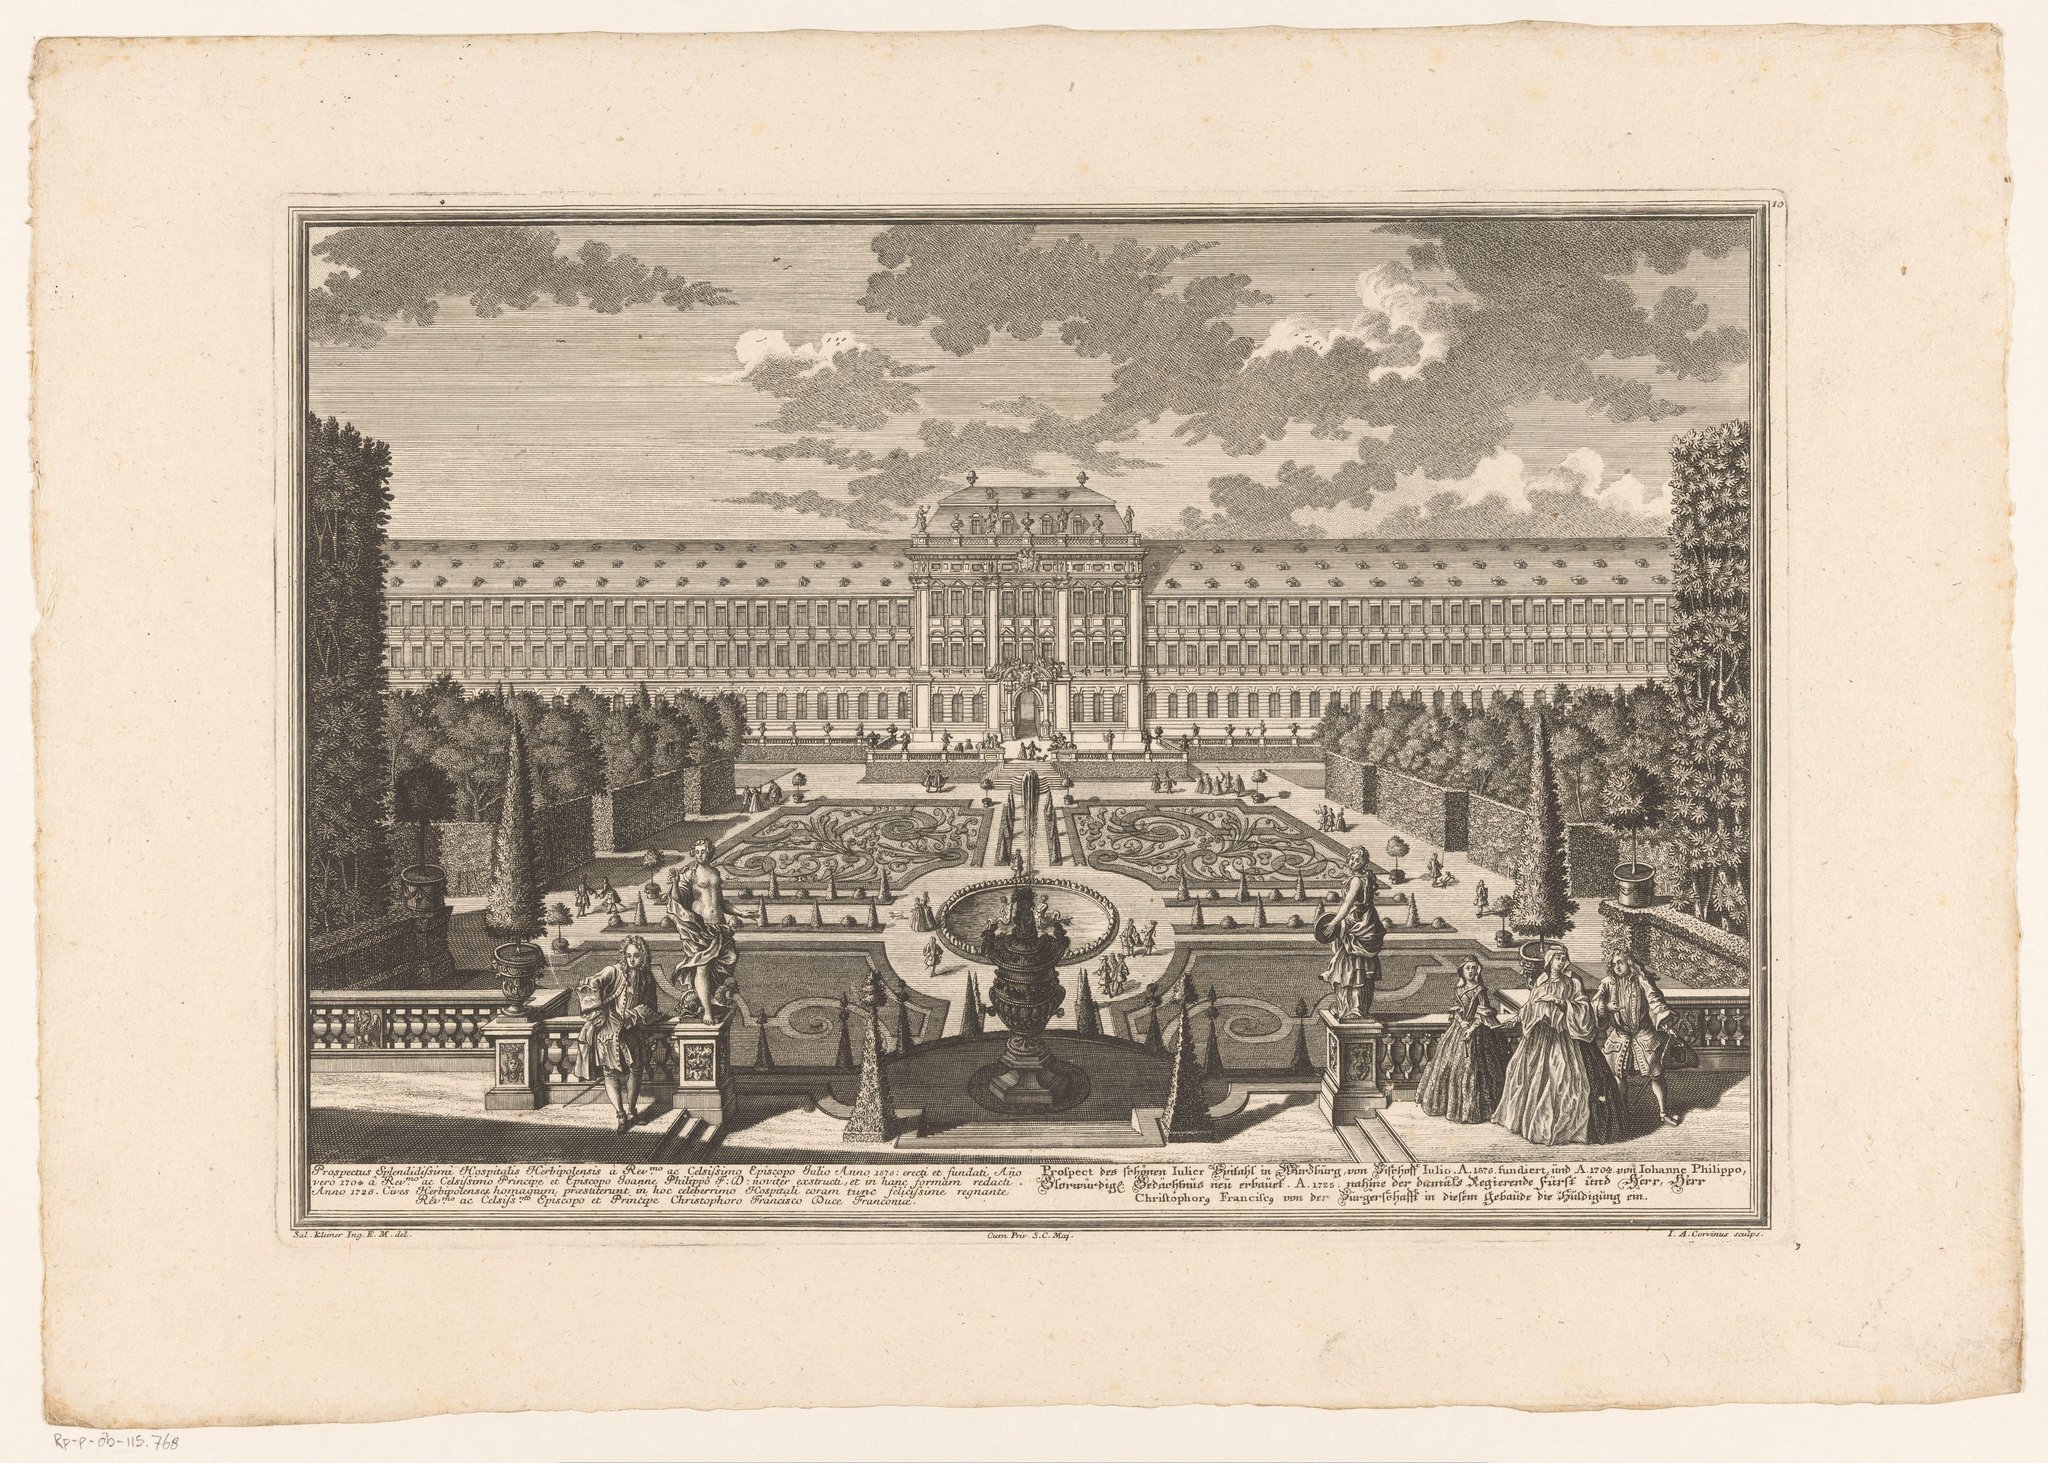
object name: print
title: Ducalis et Episcopalis Residentia Wurzburgum seu Herbipolis in Franconia (...) / Hoch-Fürstlich und Bischöffliche Residenz-Stadt Würzburg in Francken (...)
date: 1740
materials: paper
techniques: engraving, etching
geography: augsburg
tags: city-view, and landscape with man-made constructions, garden, hospital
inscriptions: collector's mark: Lugt 2228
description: Serie bestaande uit elf prenten plus een titelprent. Johann Andreas Pfeffel wordt op de titelprent aangeduid als prentmaker, maar zijn naam staat op de prenten niet vermeld.